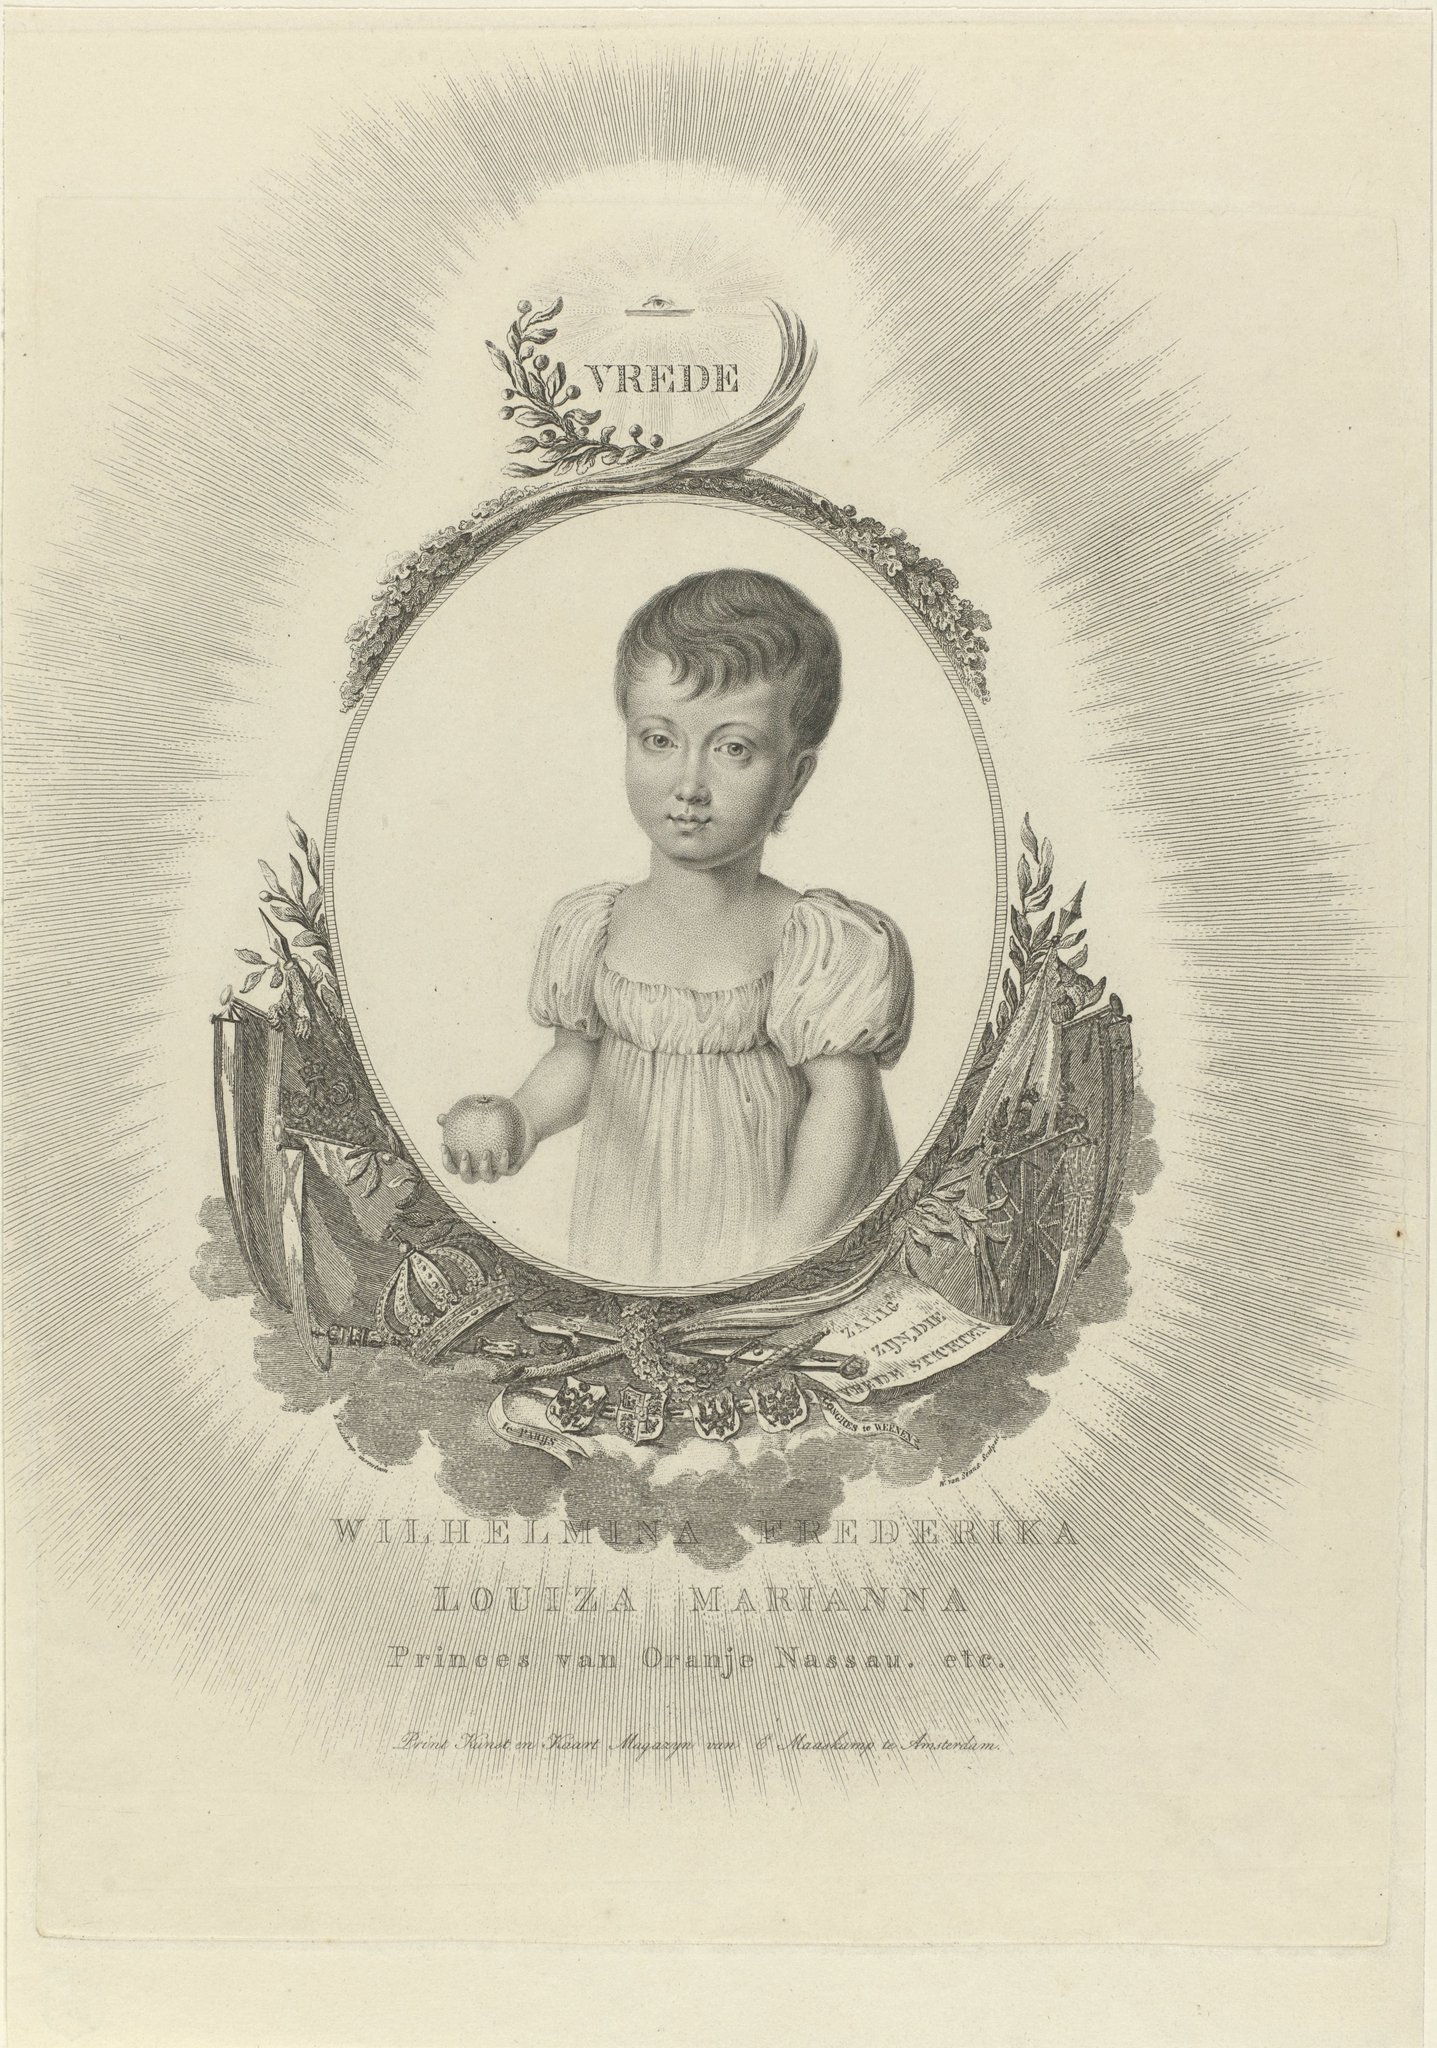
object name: print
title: Portret van Marianne, prinses der Nederlanden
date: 1815-1834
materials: paper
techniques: engraving, etching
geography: amsterdam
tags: berlin, marianne (prinses der nederlanden)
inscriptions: collector's mark: Lugt 963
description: De hier vermelde titel verwijst naar de hoogst verkregen titel van de geportretteerde, niet per se naar de titel die de geportretteerde op deze voorstelling draagt.